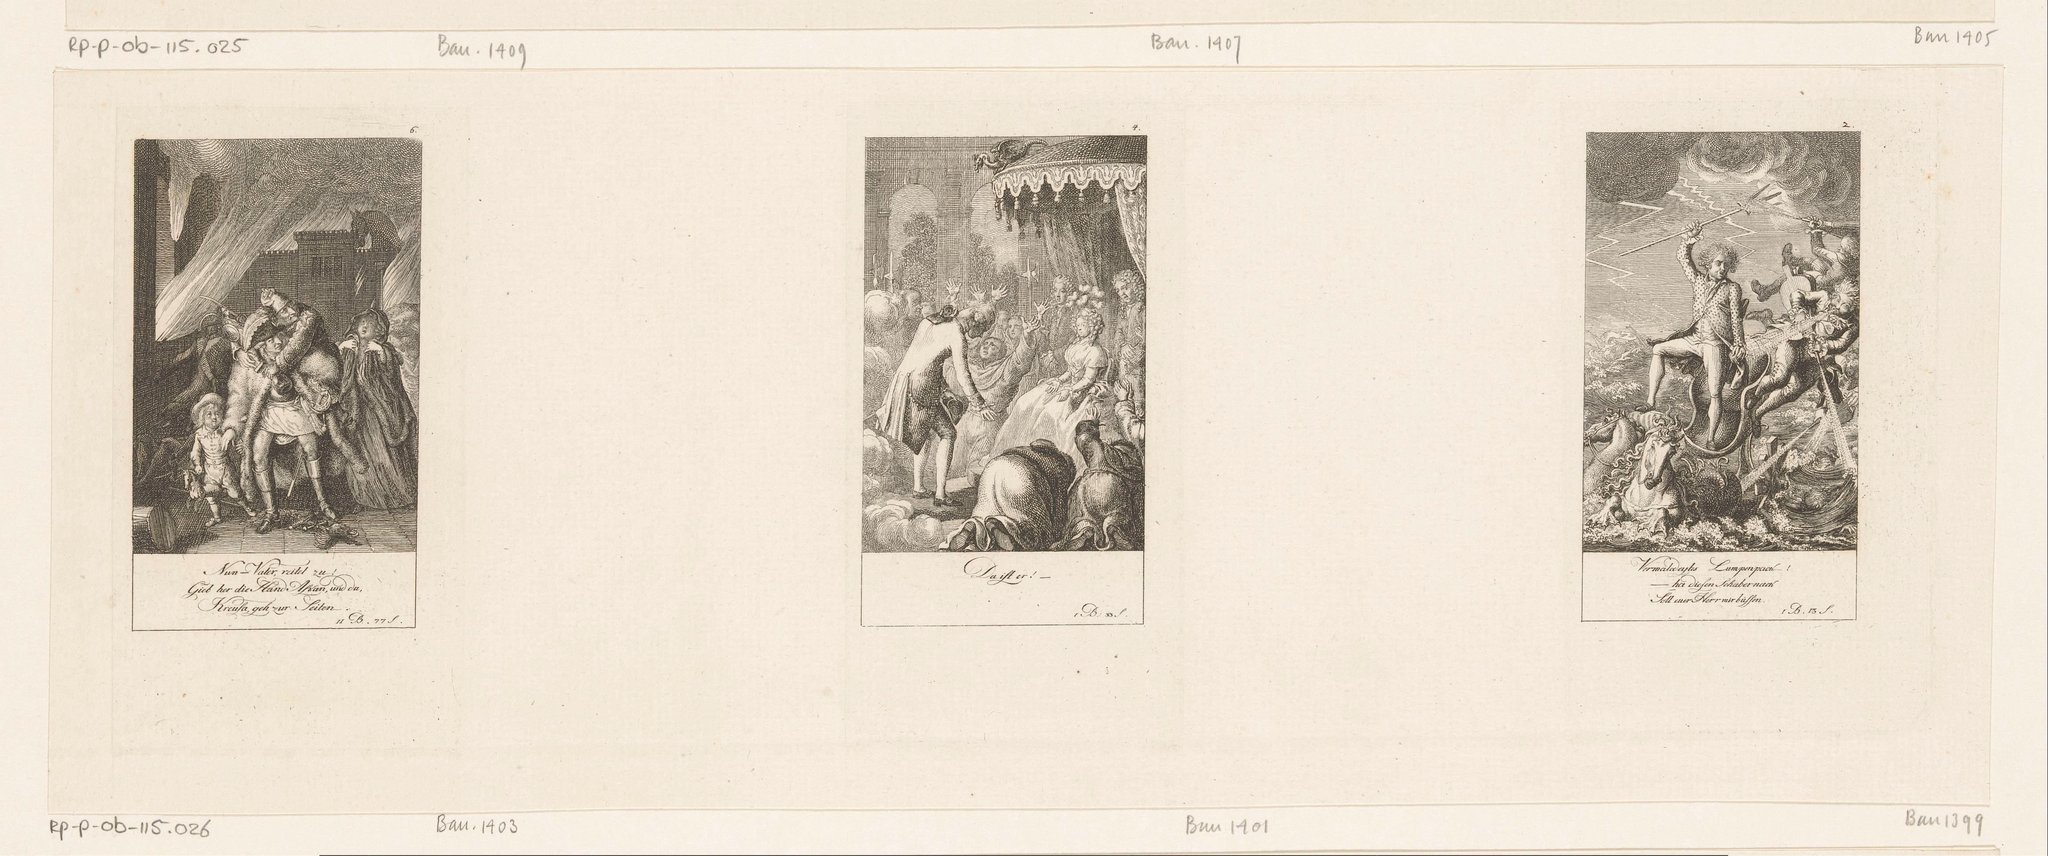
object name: print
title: Drie voorstellingen uit Blumauers Aeneide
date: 1789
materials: paper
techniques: etching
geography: lauenburg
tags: alois blumauer, literature, 'pius aeneas': aeneas, leading ascanius, escapes from burning troy, carrying his father anchises with the penates; his wife creusa, who sets out with them, is lost on the way, the meeting of aeneas and dido; when he approaches her throne, the cloud enveloping him and achates vanishes, neptune as lord of the sea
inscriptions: collector's mark: Lugt 2228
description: Vervaardigd voor Johann Aloys Blumauers 'Aeneide'. Prenten gebruikt voor: Königl. Grossbrit. Genealogischer Kalender auf das Jahr 1790. Lauenburg: J. G. Berenberg, [1789].